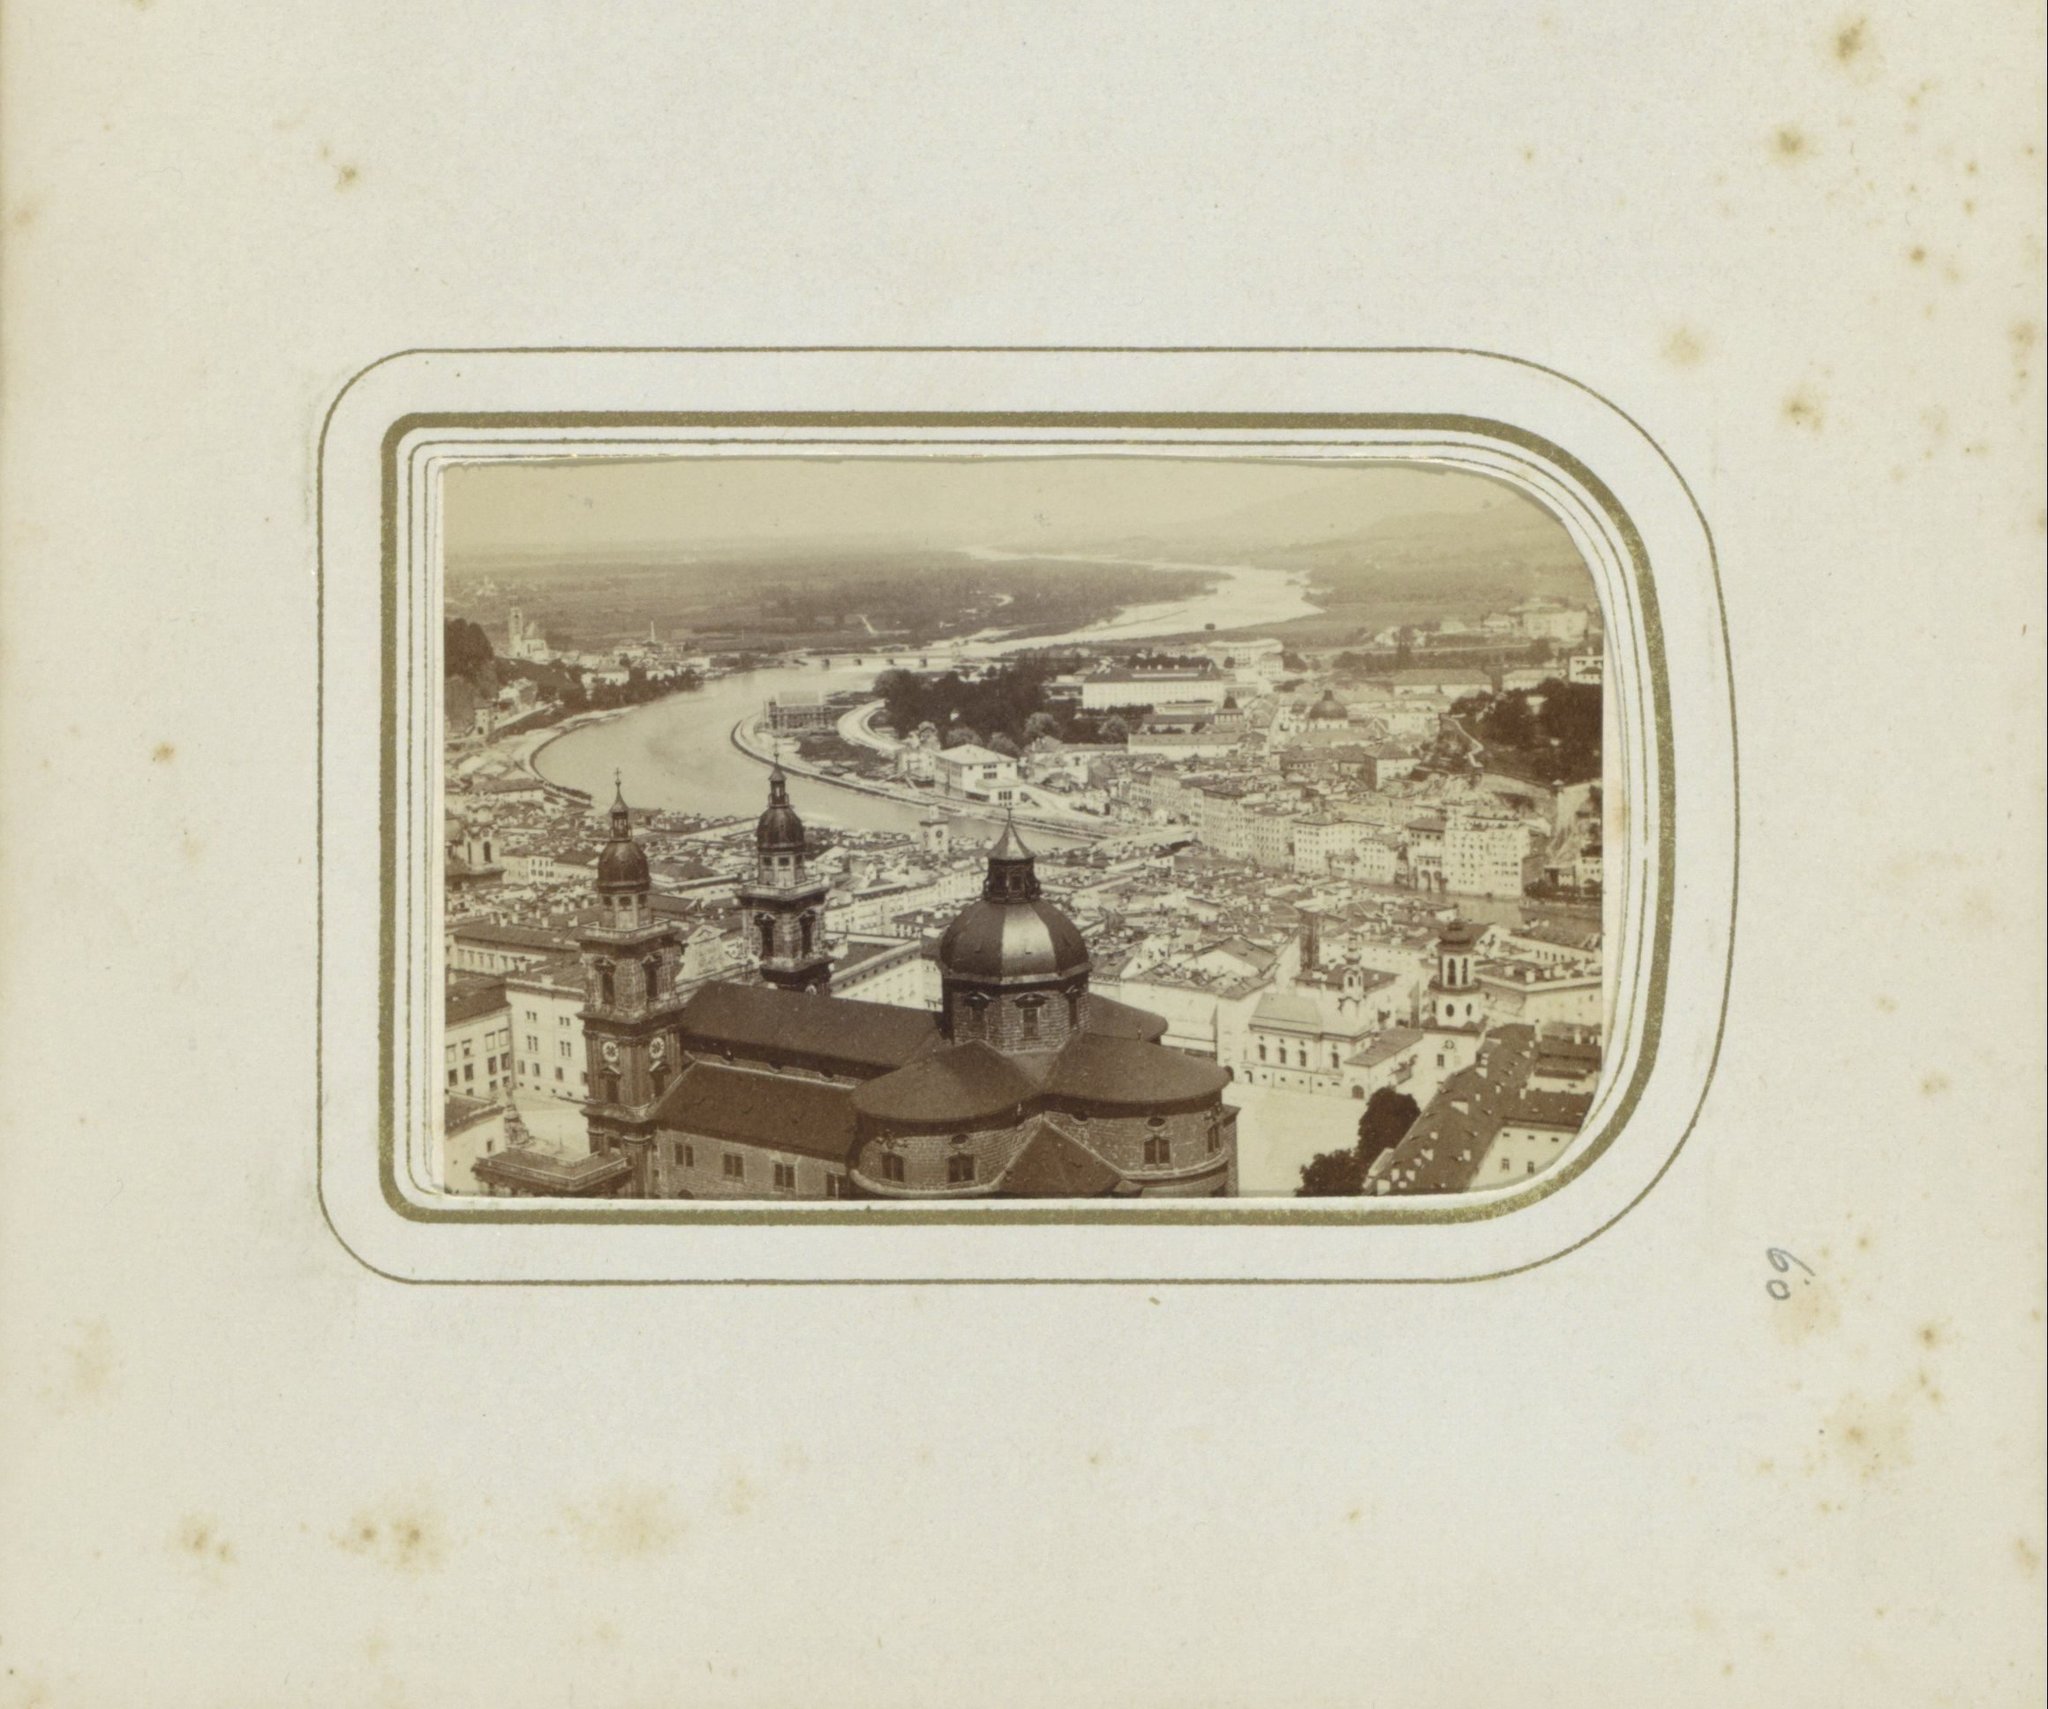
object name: photograph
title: Gezicht op Salzburg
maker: Anonymous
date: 1865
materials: paper, photographic support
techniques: albumen print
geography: drievuldigheidskerk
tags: river, waterfall, church (exterior), travelling; tourism, parts of church exterior and annexes: tower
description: Onderdeel van Fotoalbum van een reis door Zwitserland, Oostenrijk en Duitsland door de Nederlandse familie Derkinderen.